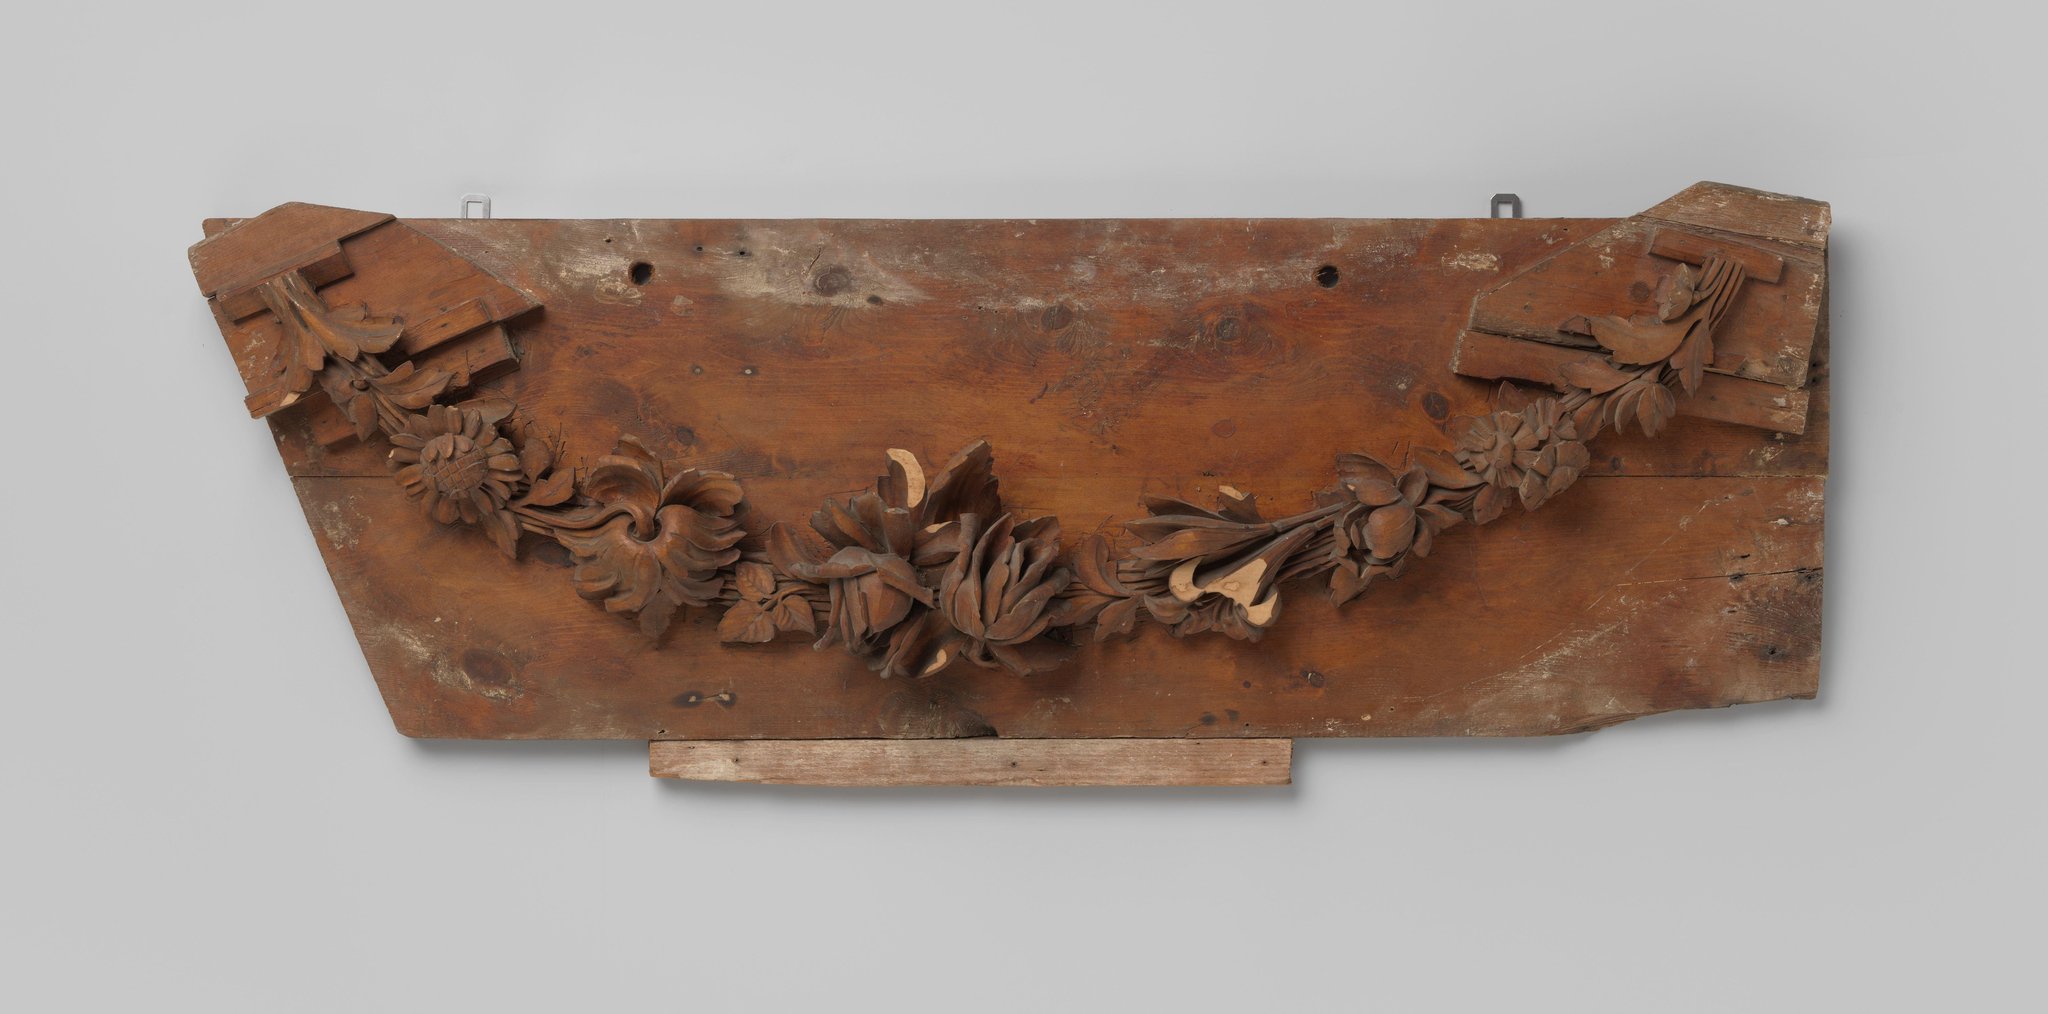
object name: furniture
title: Beeldhouwwerkmodel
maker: Anonymous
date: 1800-1900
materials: wood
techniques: cutting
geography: netherlands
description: Beeldhouwwerkmodel: snijwerk, proefmodel of voorbeeld in de vorm van een guirlande met bloem- en bladwerk.